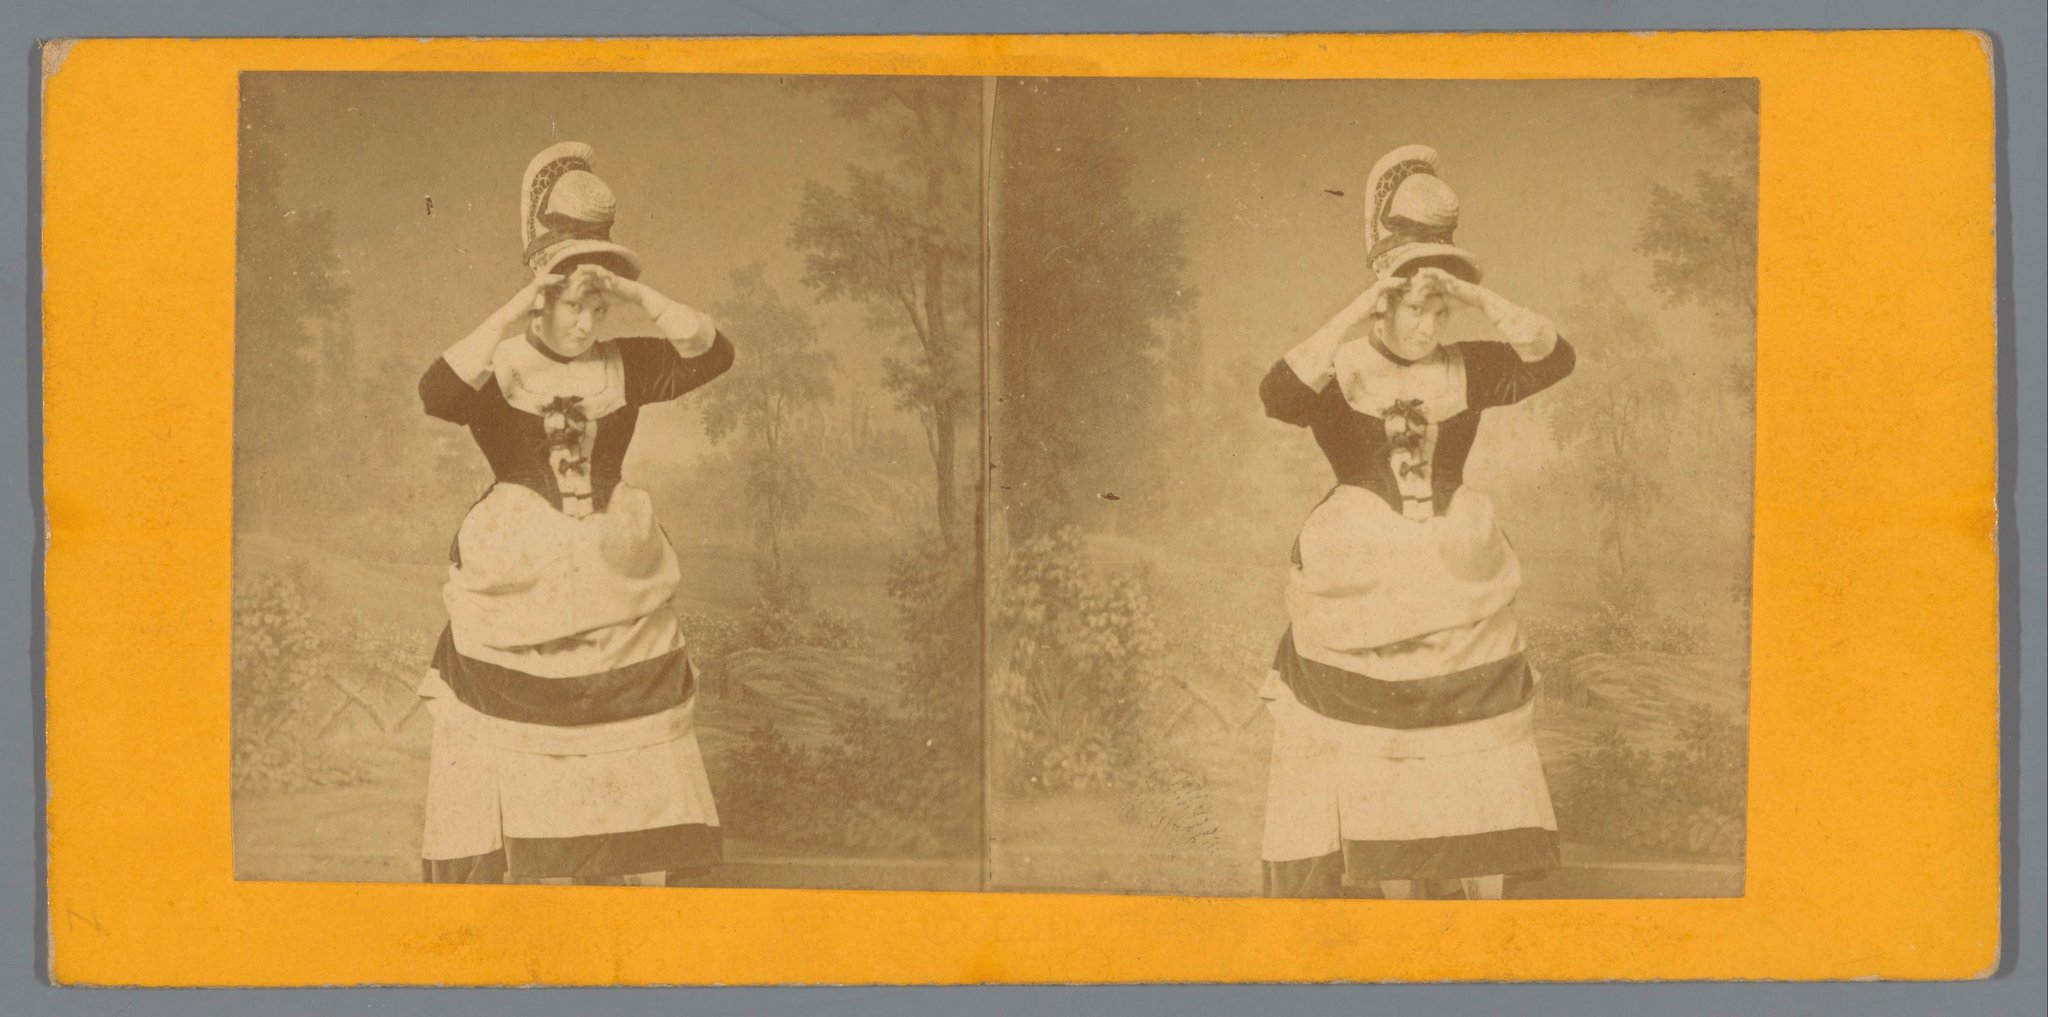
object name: stereograph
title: Portret van een vrouw in klederdracht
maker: Anonymous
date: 1850-1880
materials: cardboard, photographic support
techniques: albumen print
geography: europe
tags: folk costume, regional costume, europe